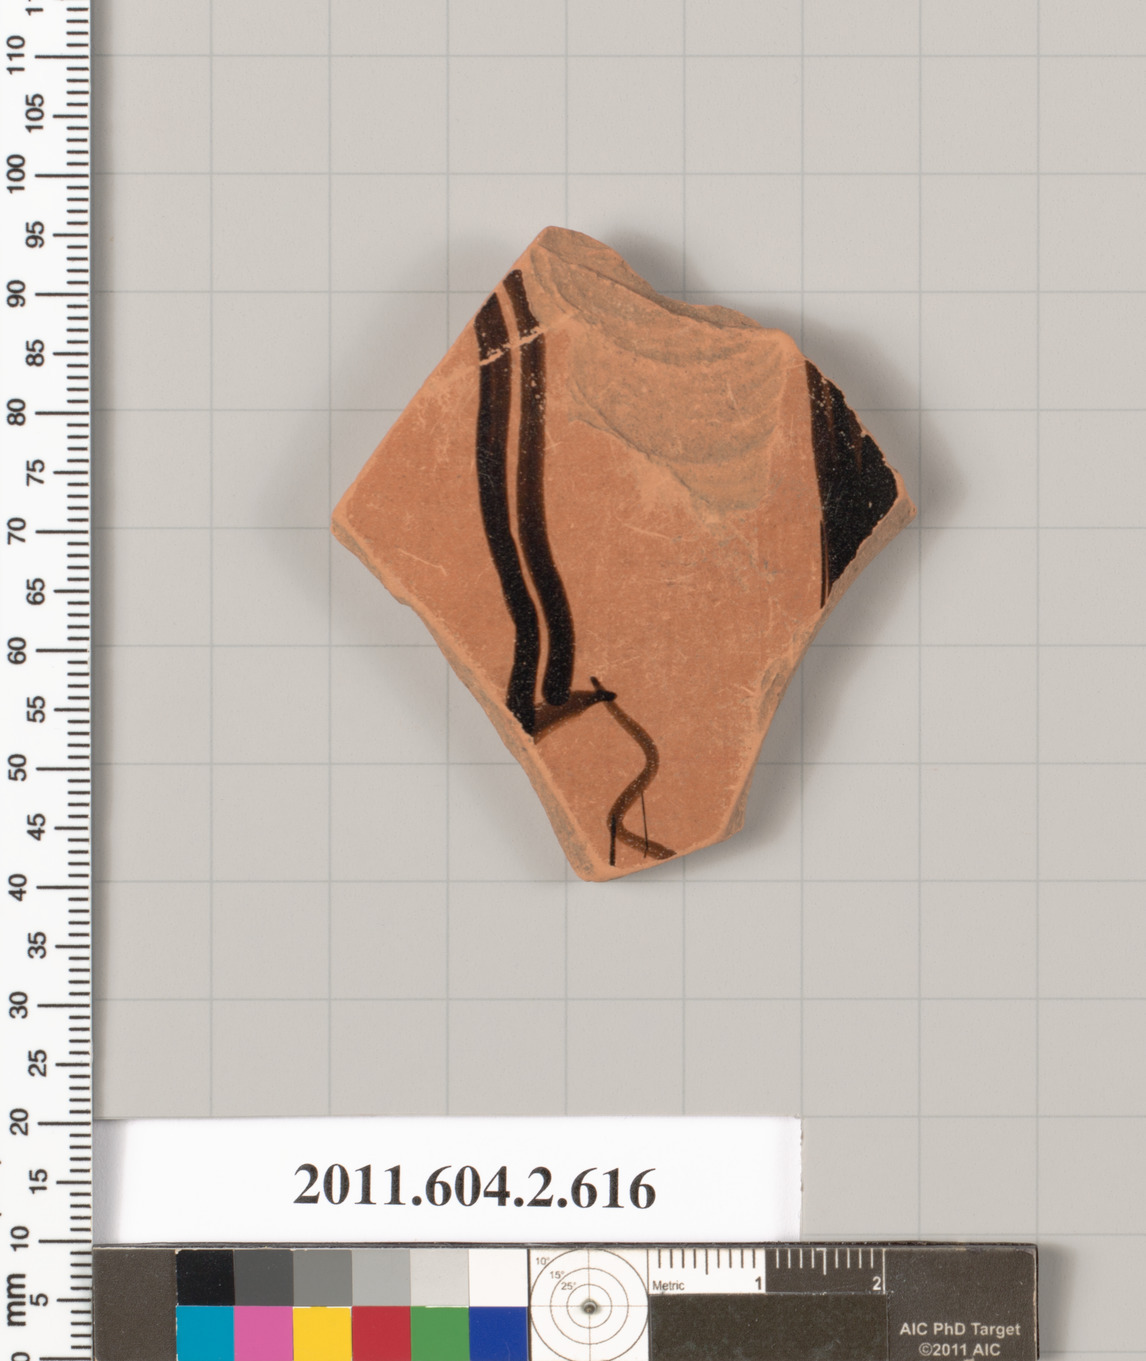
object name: column krater fragment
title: Terracotta fragment of a column-krater (bowl for mixing wine and water)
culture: greek, attic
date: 460-440 BCE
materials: terracotta